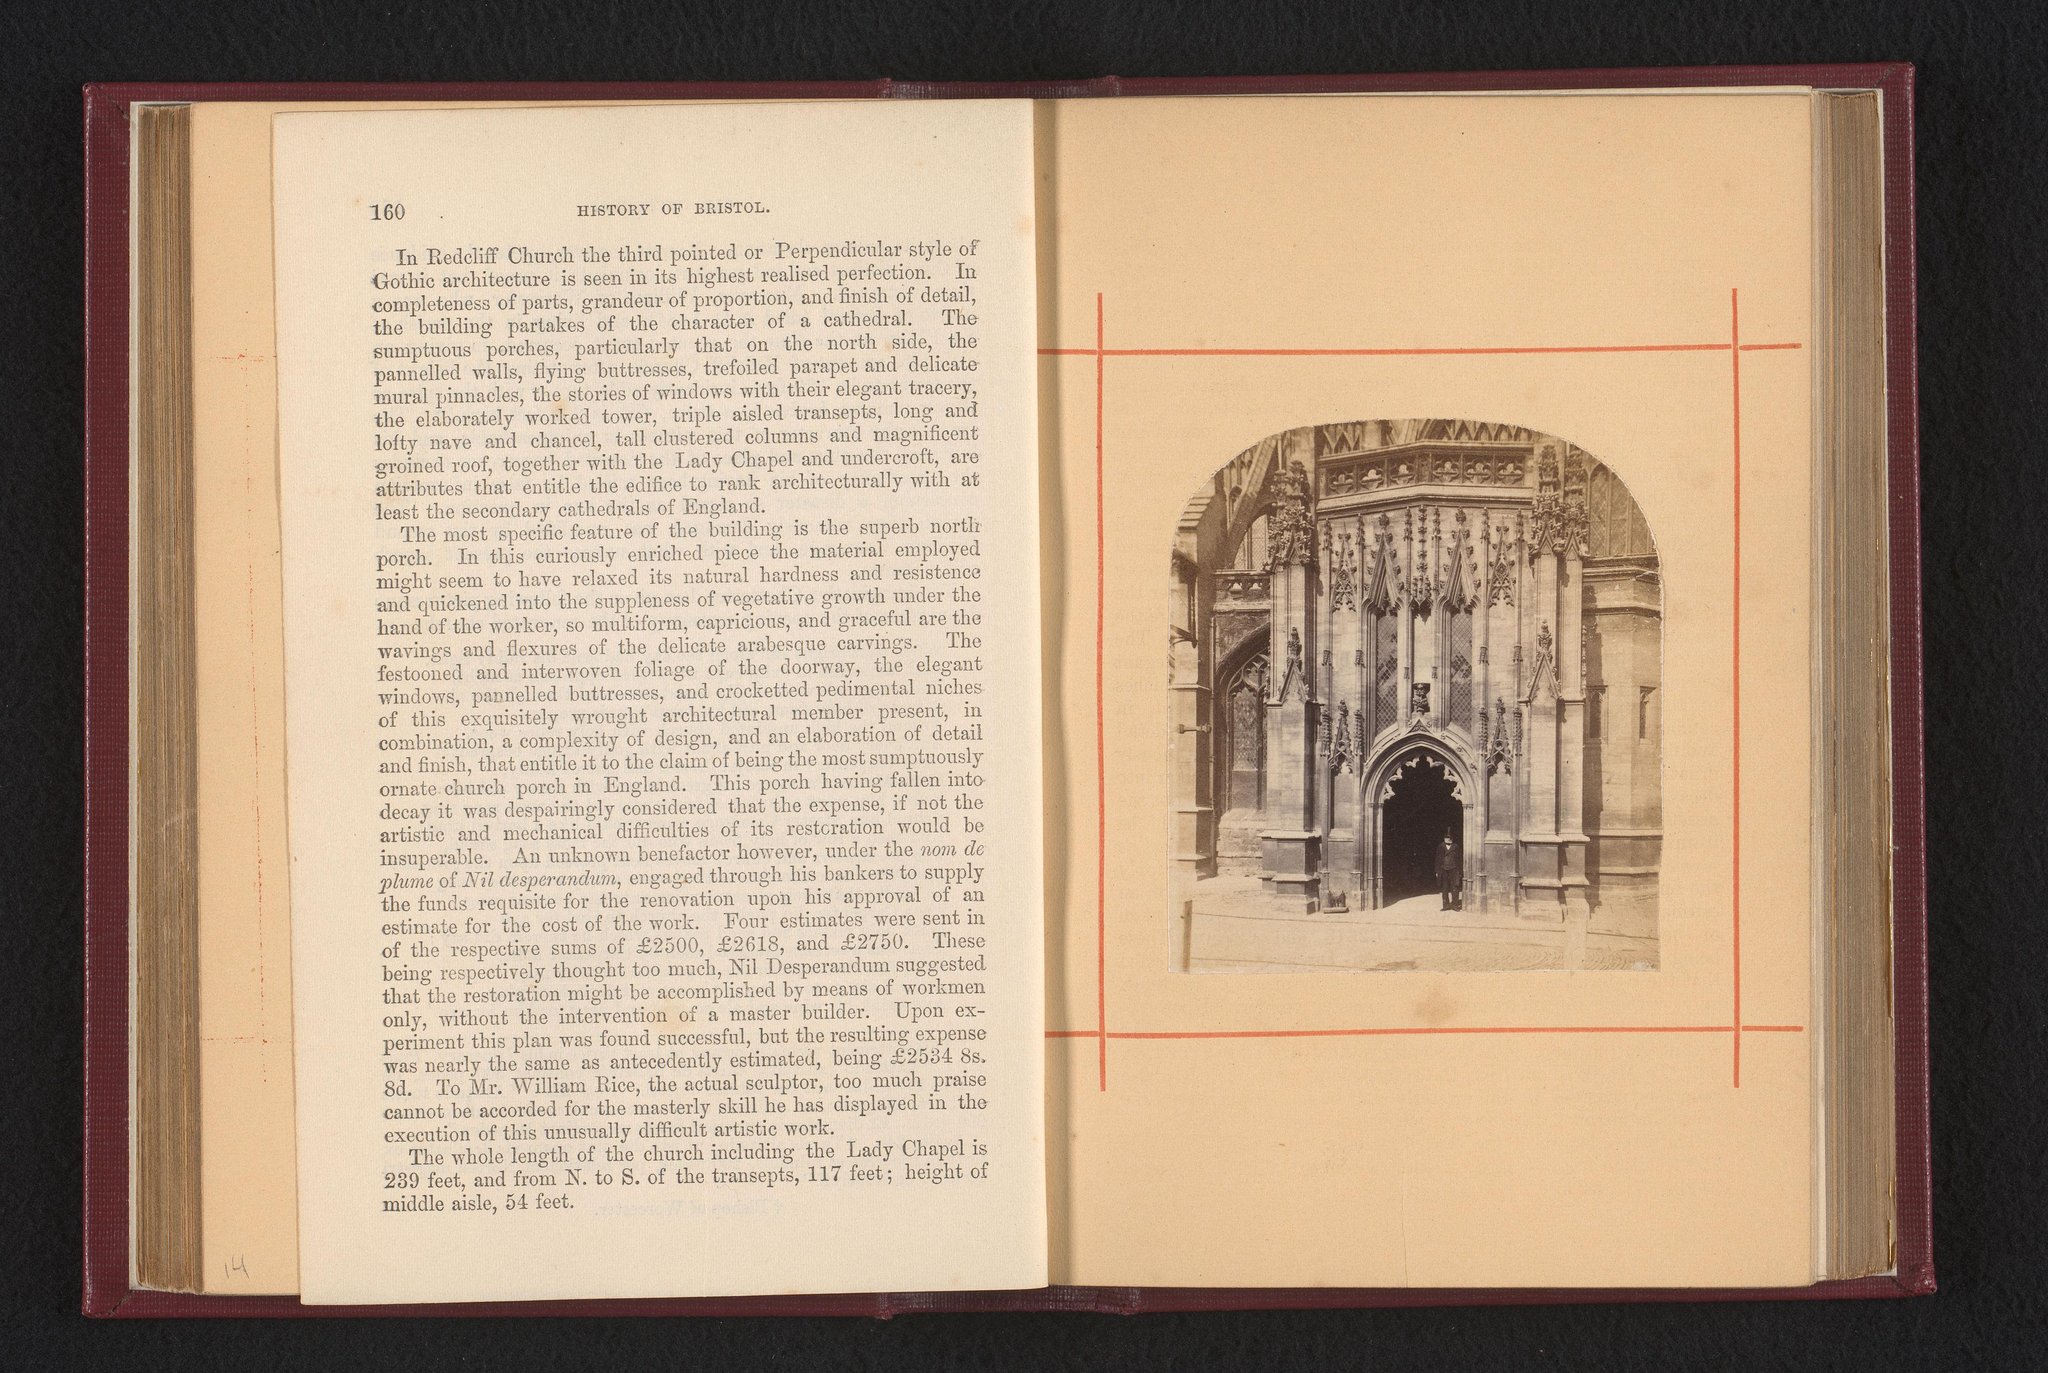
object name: photograph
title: Gezicht op een deur van St Mary Redcliff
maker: Anonymous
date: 1867-1872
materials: photographic support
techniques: albumen print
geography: bristol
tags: open door, church (exterior)